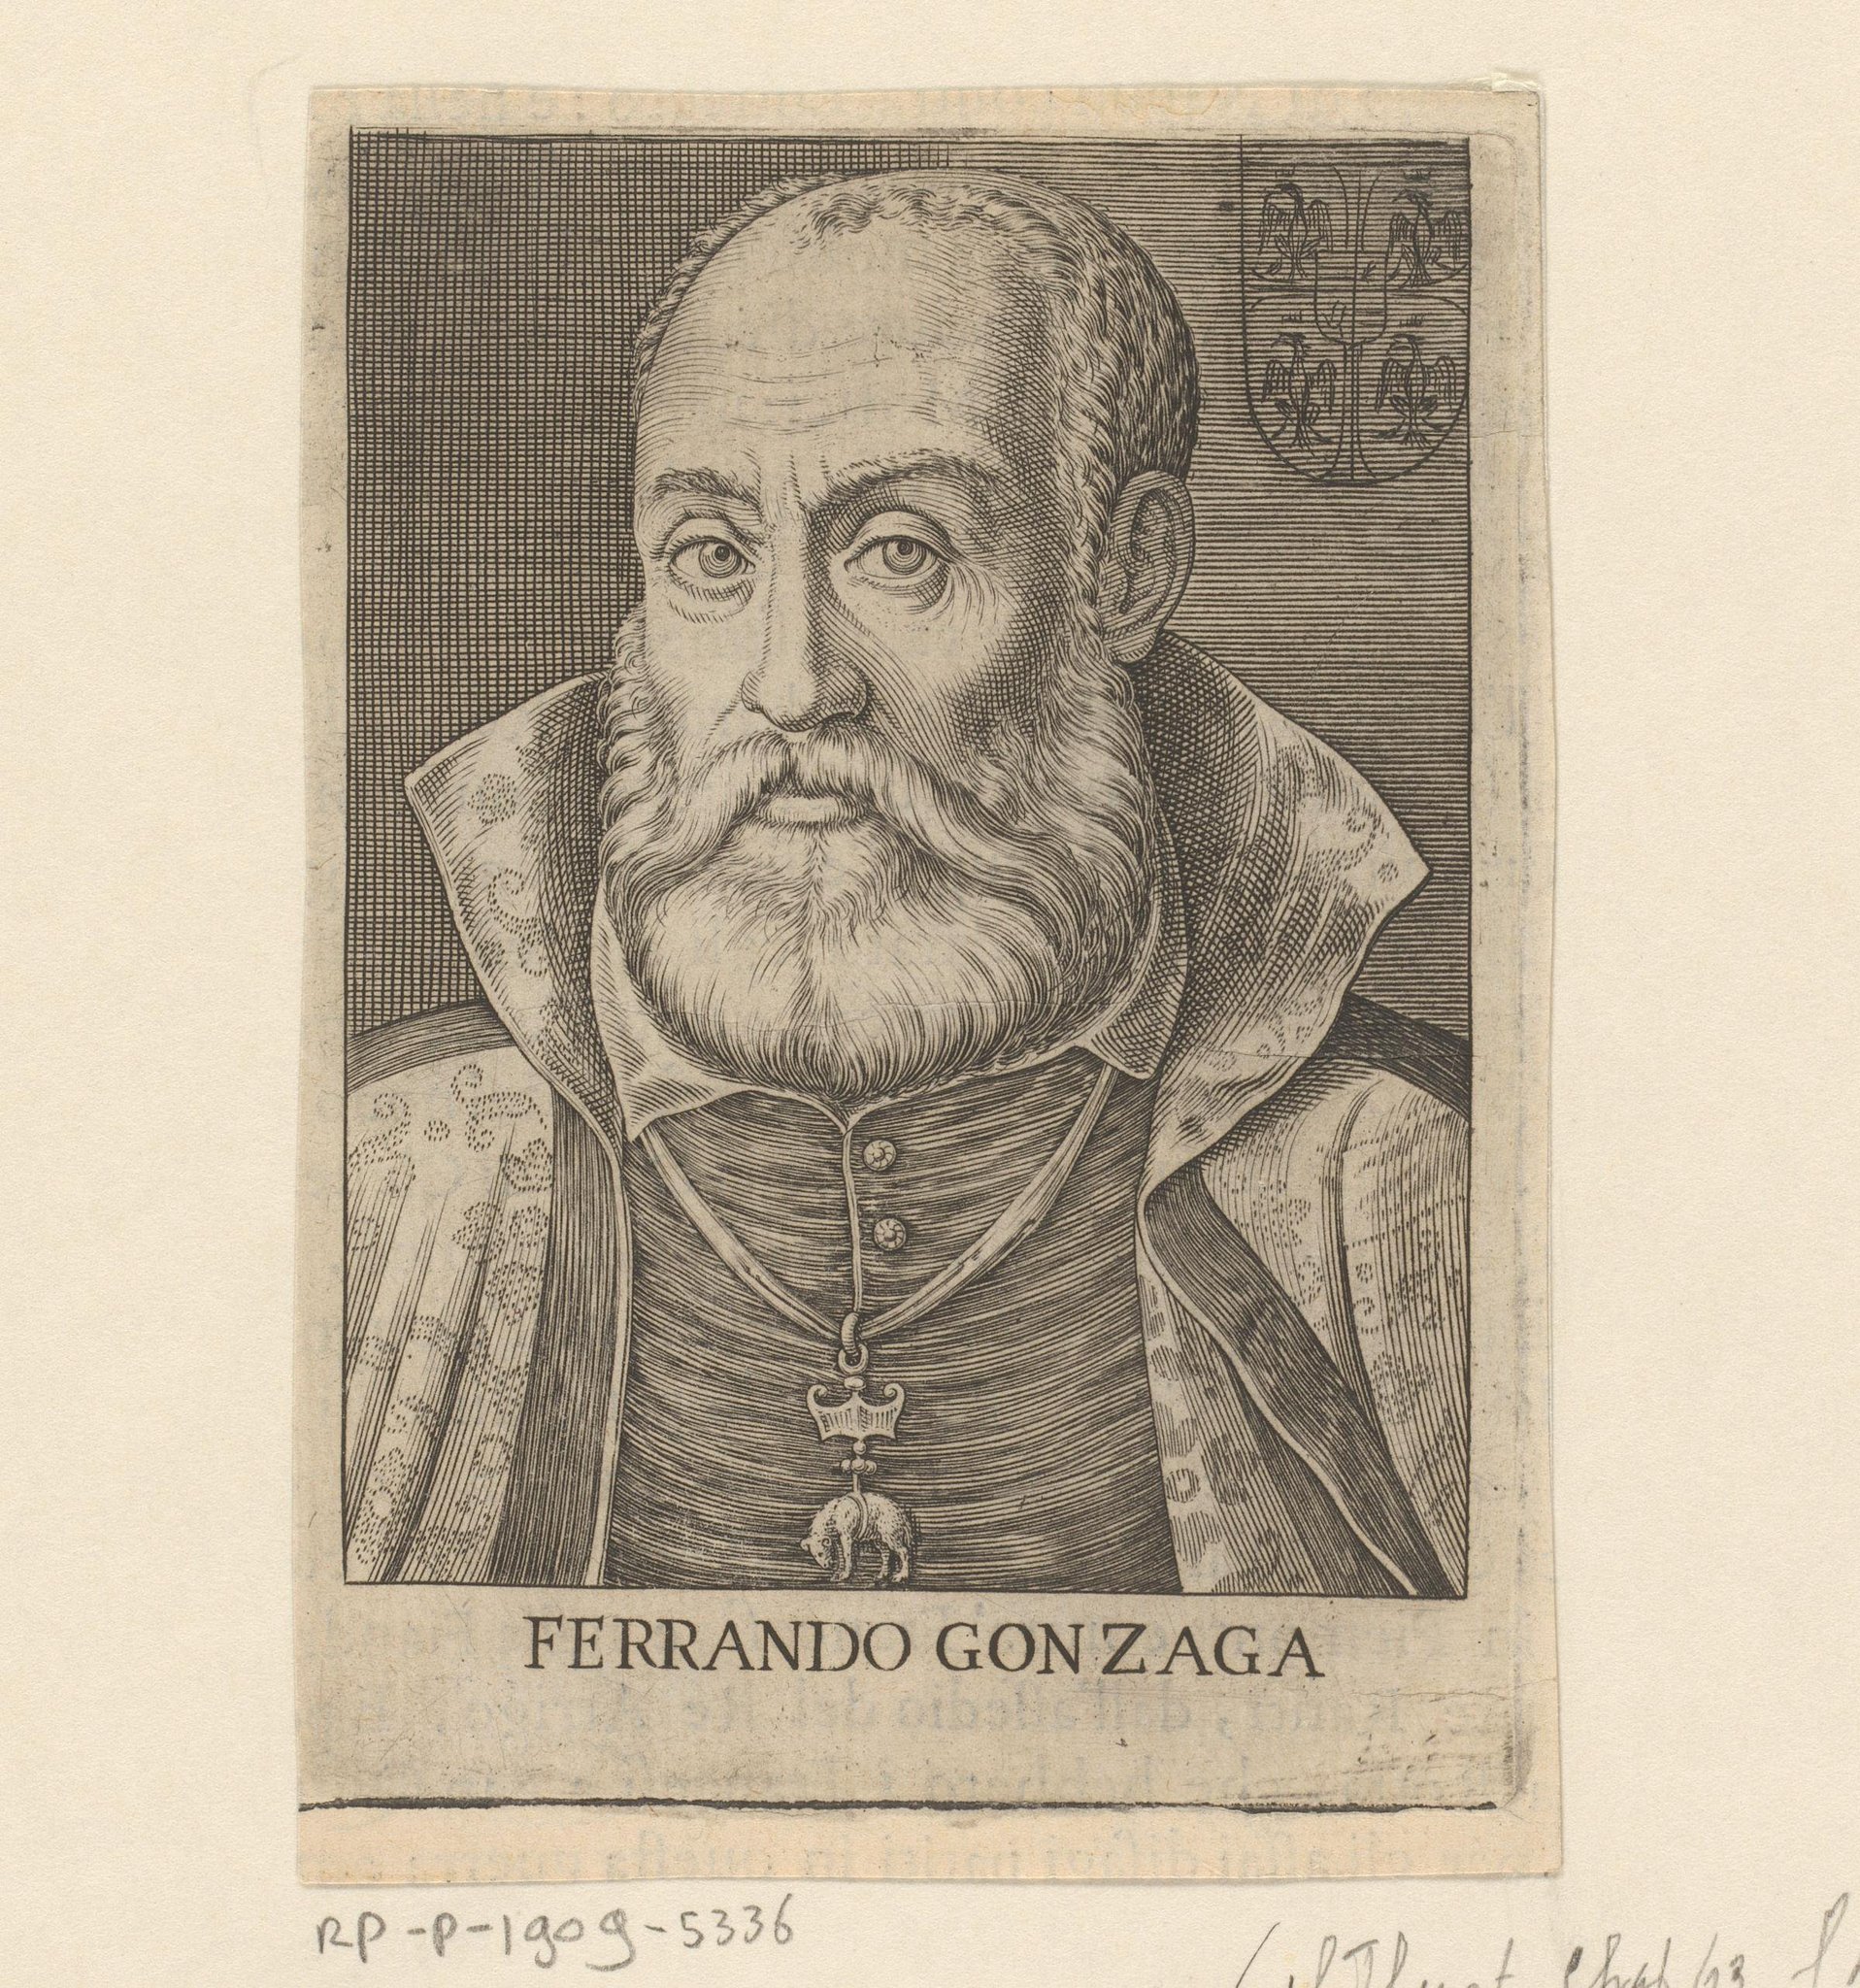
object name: print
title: Portret van Ferrante Gonzaga I, hertog van Guastalla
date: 1646-1647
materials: paper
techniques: letterpress printing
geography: rome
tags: brussels, commander-in-chief, general, marshal, historical persons, armorial bearing, heraldry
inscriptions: collector's mark: Lugt 2228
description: Prent uit: Ritratti et elogii di capitani Illustri. Che ne'secoli moderni hanno gloriosamente guerreggiato. Rome: Filippo de'Rossi en Vitale Mascardi, 1646, p. 309. Prent ook gebruikt in dezelfde editie van 1647. Eerdere staten van prent in ieder geval gebruikt in: Ritratti et elogii di capitani Illustri. Rome: Pompilio Totti en Andrea Fei, 1635. En in: Ritratti di cento capitani illustri con li lor Fatti in guerra (…), Rome: Domenico Gigliotti, 1596.